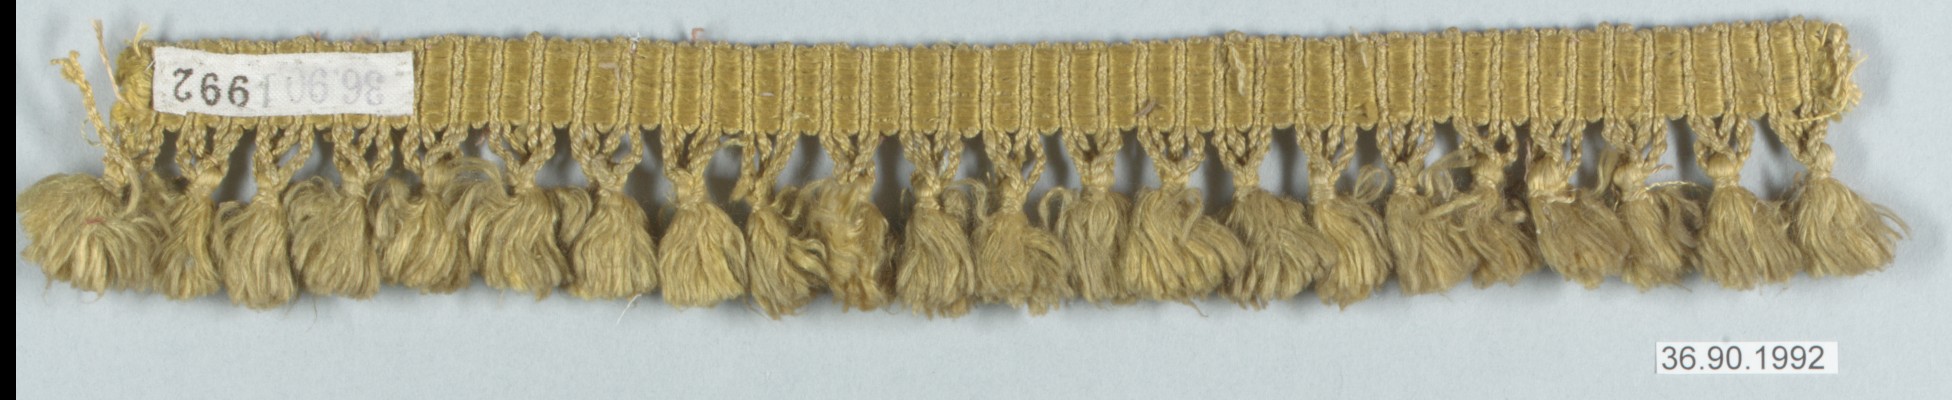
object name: fringe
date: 1734-1766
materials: silk